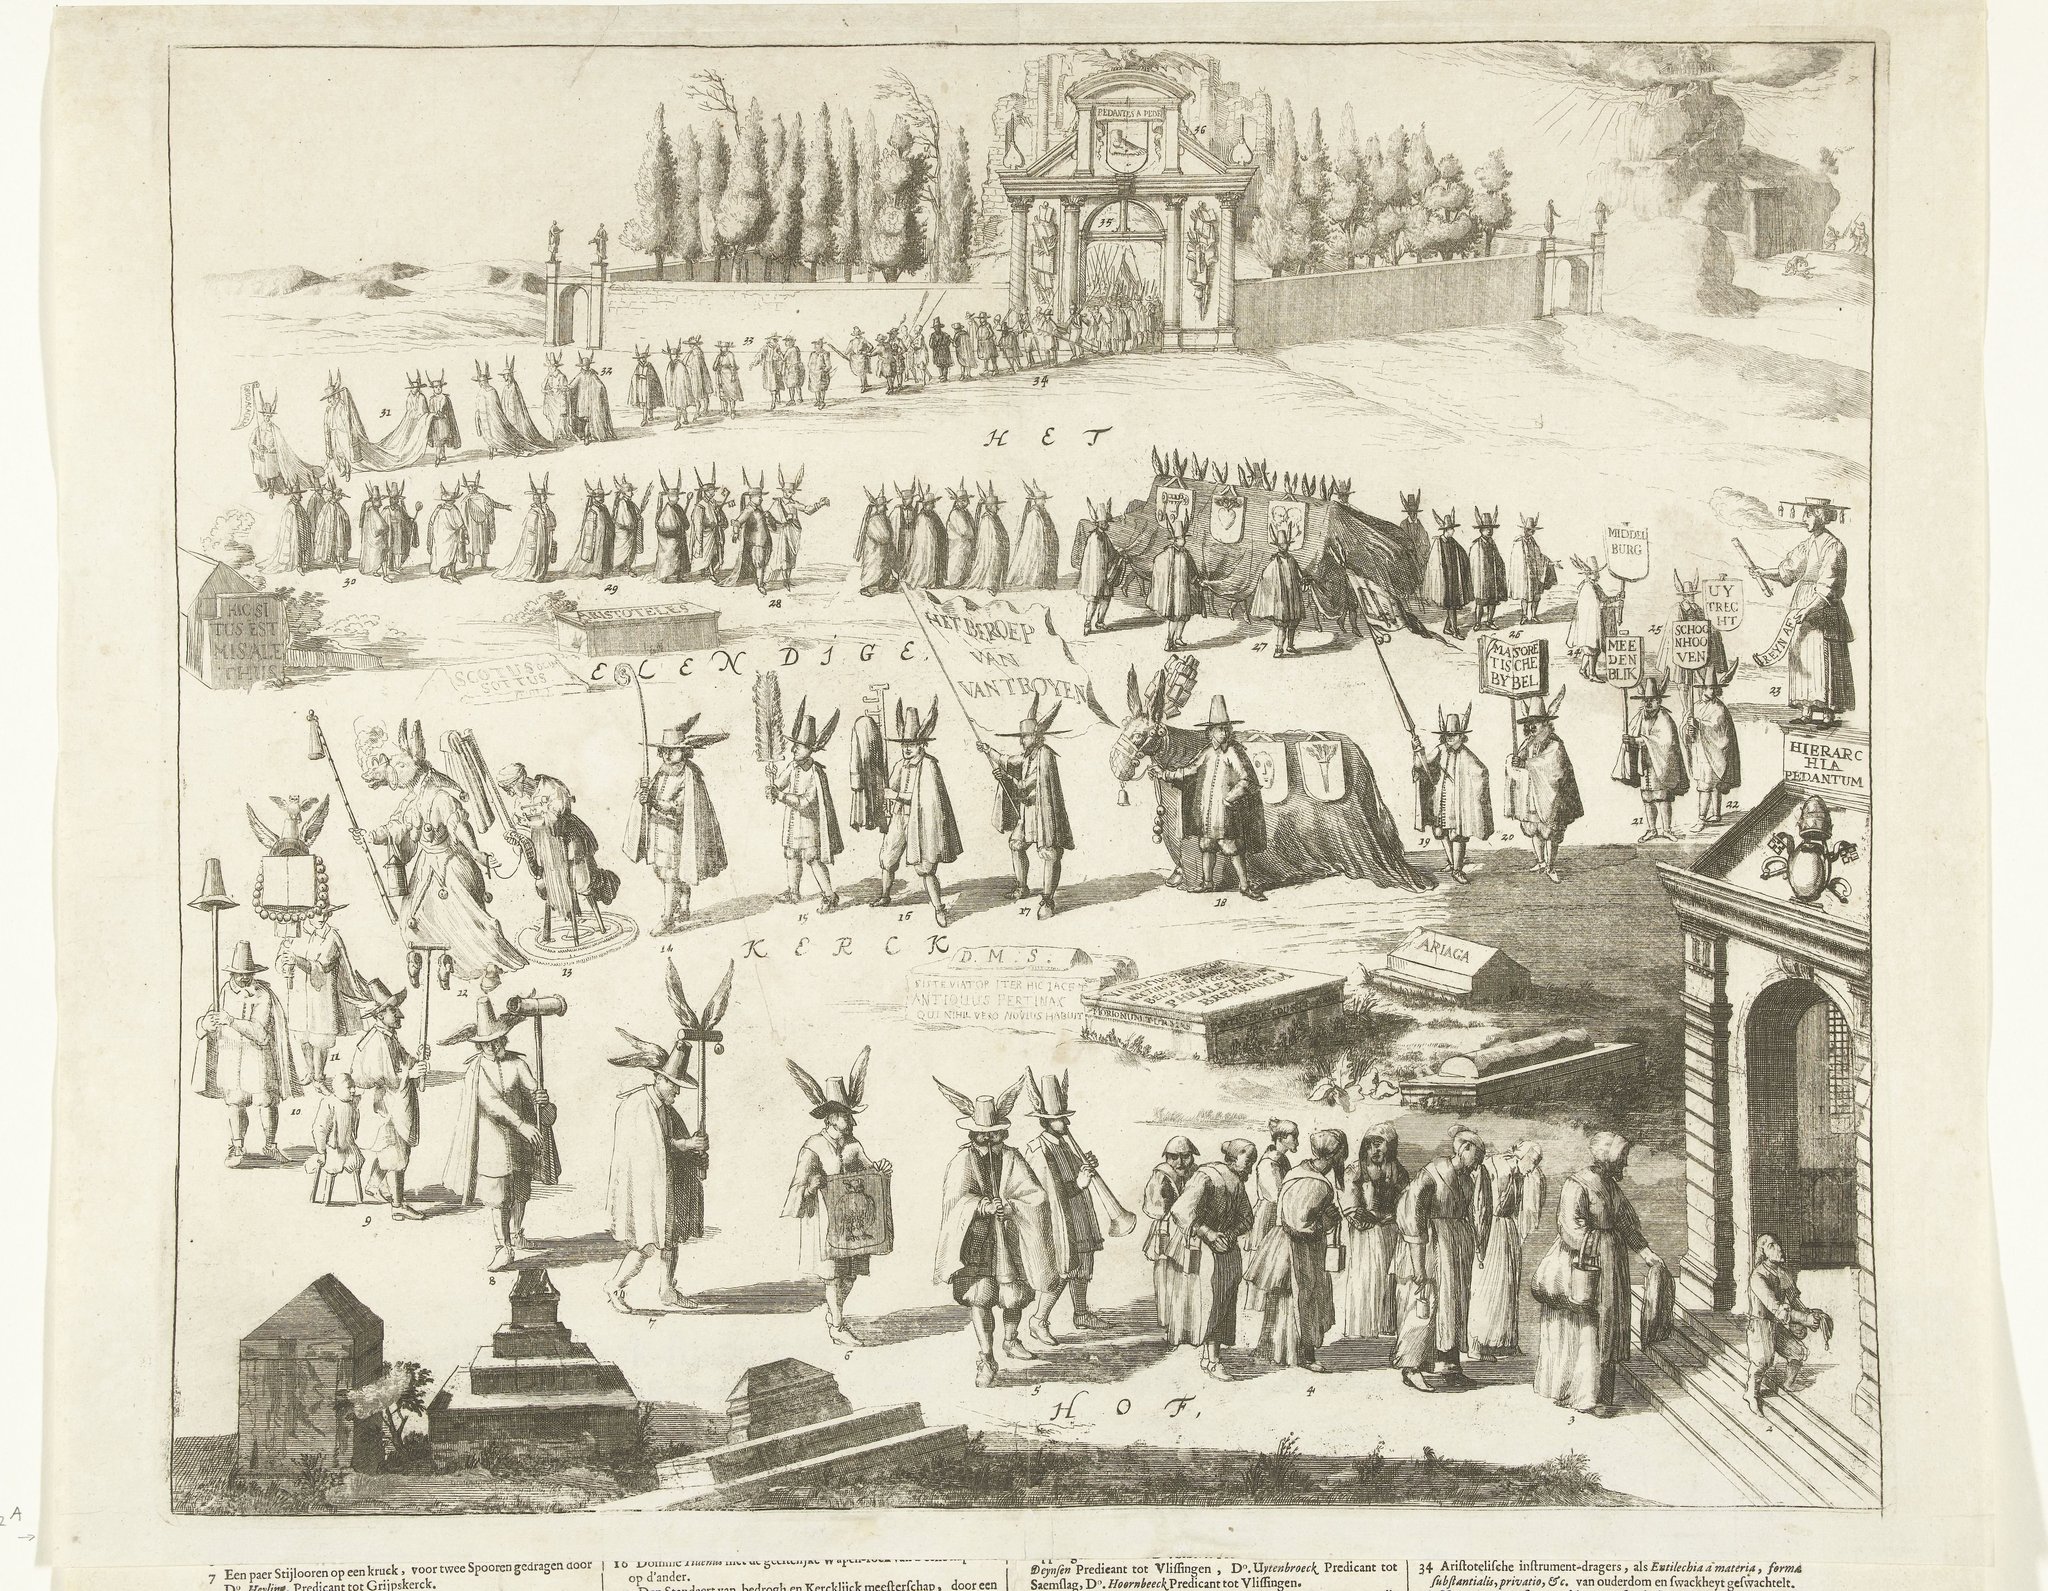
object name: cartoon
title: Spotprent van de begrafenis van dominee Abraham van de Velde, 1677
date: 1677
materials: paper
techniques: etching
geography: amsterdam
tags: cortege, funeral procession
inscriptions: caption: ‘De Kerkelijkcke Lijck-statie .../... van de nieuwe Secte.’, inscription: ‘HET ELENDIGE KERCK HOF’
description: Spotprent van de begrafenis van dominee Abraham van de Velde, 14 juni 1677. Een lange begrafenisstoet van 4 rijen mannen met steiloren of ezelsoren trekt met het lijk van ds. van der Velde uit het Huis van Onrust over 'het elendige kerckhof', langs enige grafzerken met toepasselijke opschriften naar de kerk van de Geestelijke Oppermogendheid. Enige huilende zusters voeren de stoet aan; in het midden een vaandel met opschrift 'Het beroep van Troyen'. Bij de prent behoort een tekstlad met legenda. De voetiaanse dominee was eerder uit Utrecht verbannen en speelde in 1675 een rol in het conflict in Zeeland tussen de voetianen en coccejanen.